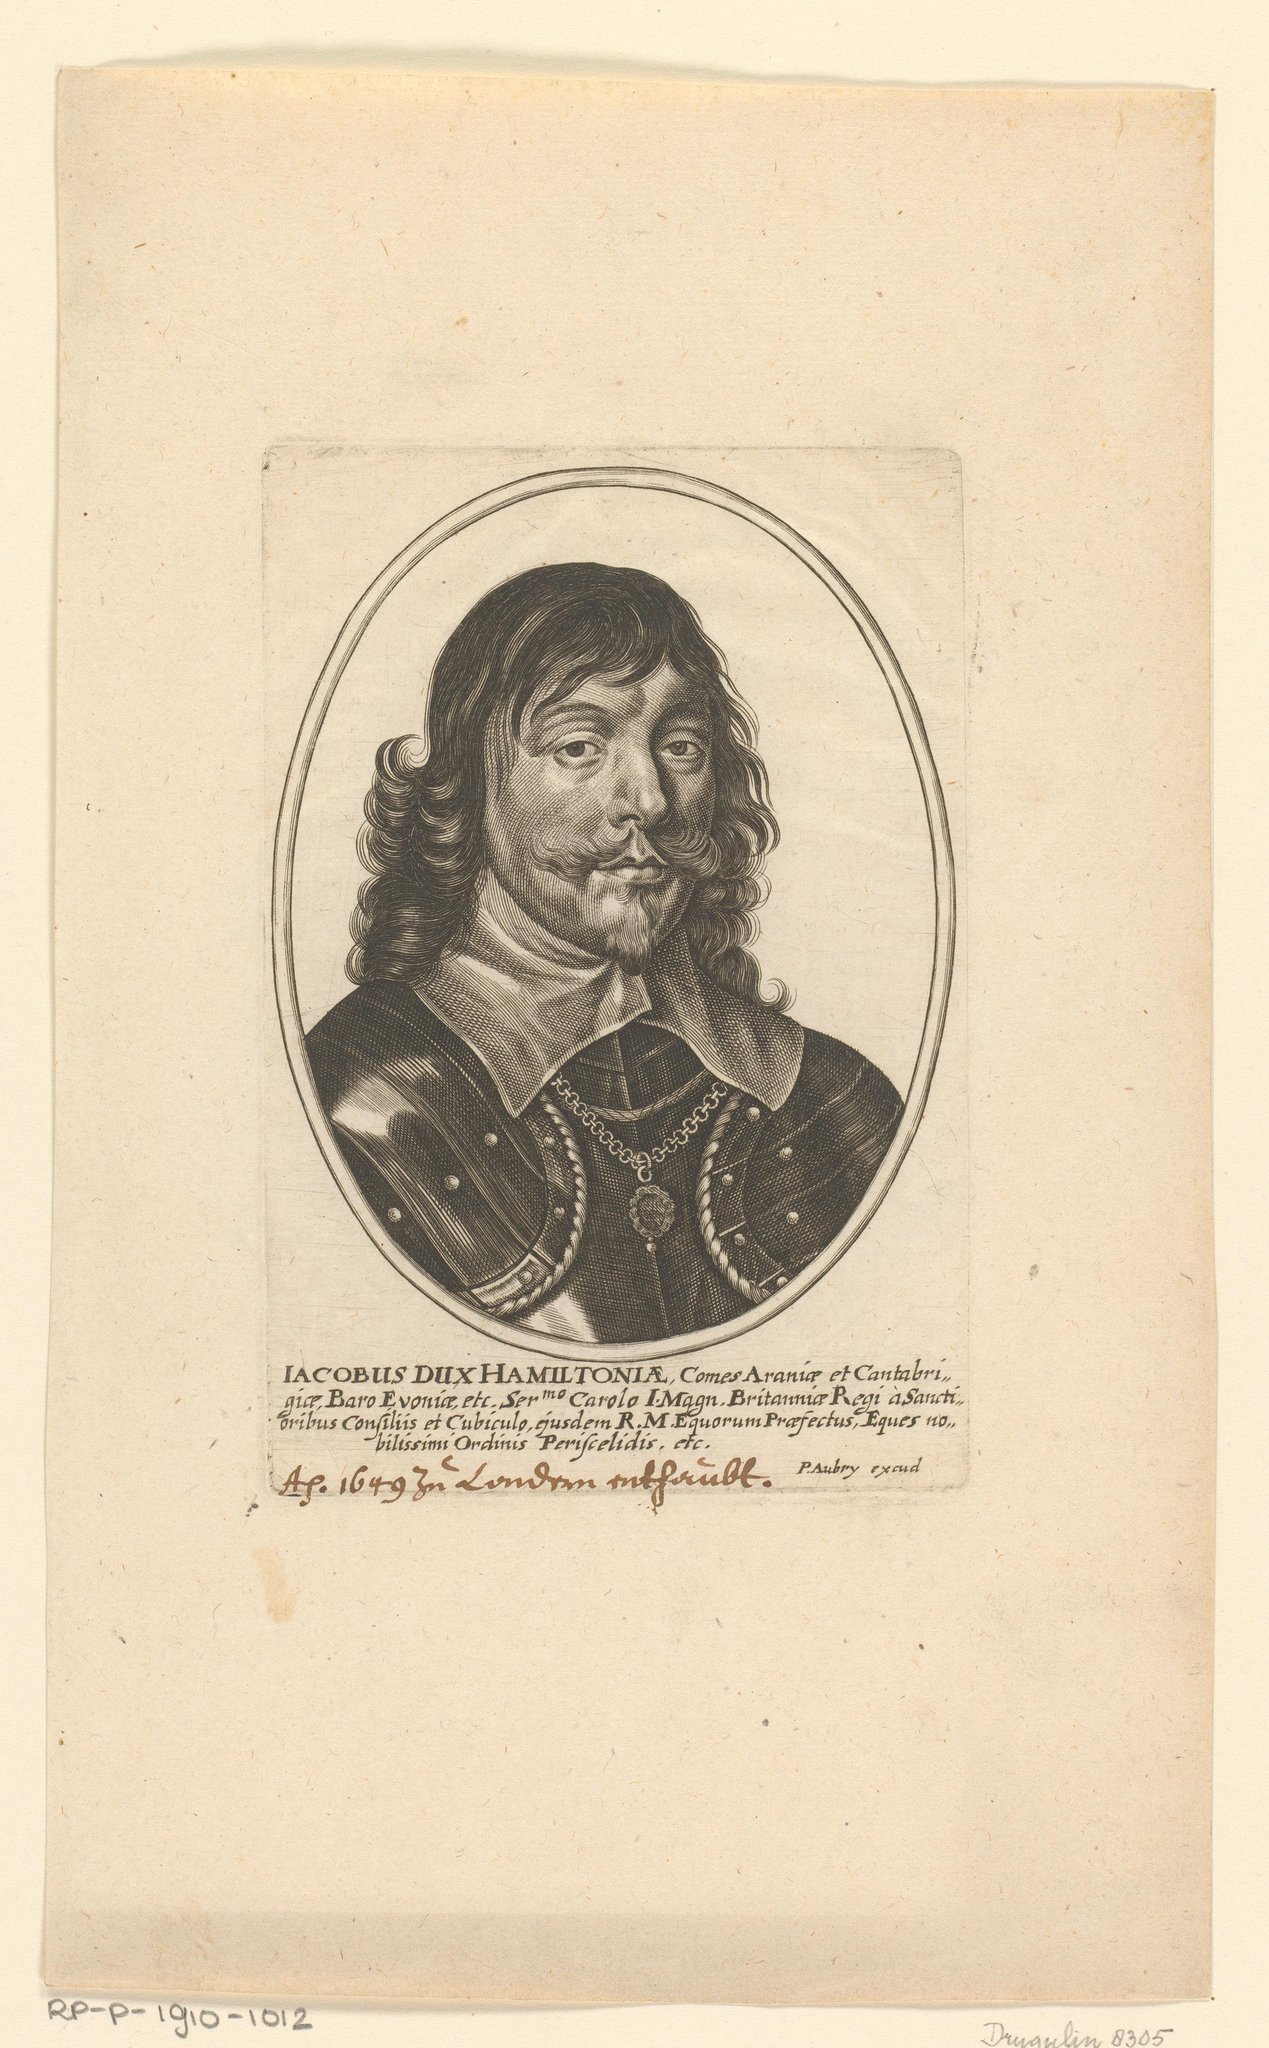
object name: print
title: Portret van James Hamilton I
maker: peter aubry (ii)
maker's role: print maker, publisher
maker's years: 1596-1668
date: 1636-1686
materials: paper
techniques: engraving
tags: earl, historical persons, ruler, sovereign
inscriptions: inscription: ‘As. 1649 zu London intsrubt (?).’, collector's mark: Lugt 2228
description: Met vierregelig onderschrift in het Latijn.